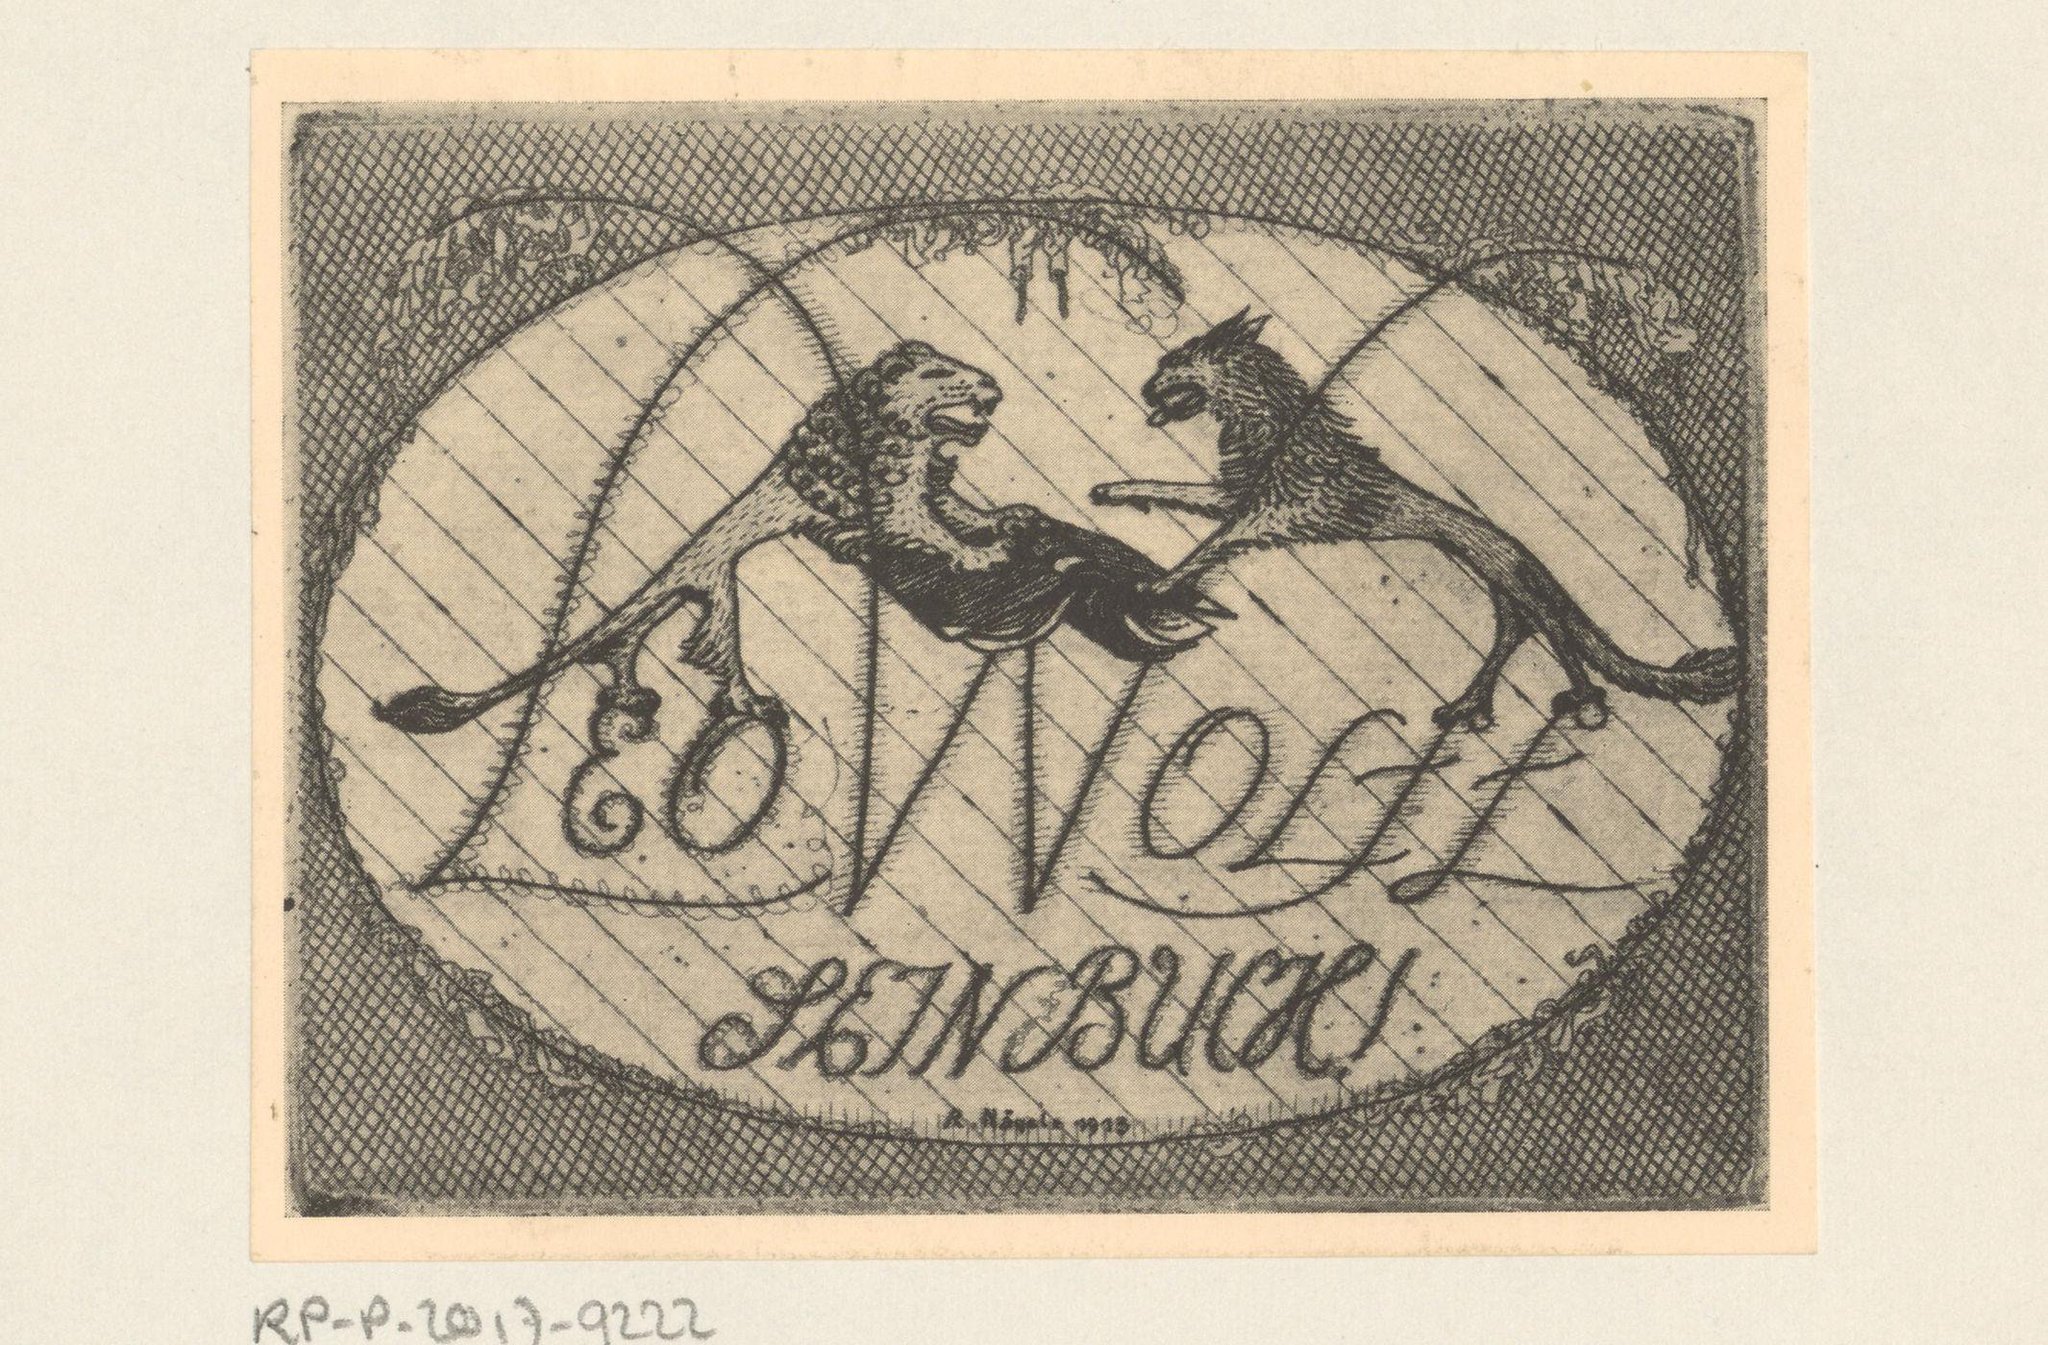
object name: bookplate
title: Ex libris van Leo Wolff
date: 1913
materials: paper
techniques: autotype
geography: germany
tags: beasts of prey, predatory animals: lynx, beasts of prey, predatory animals: lion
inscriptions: date